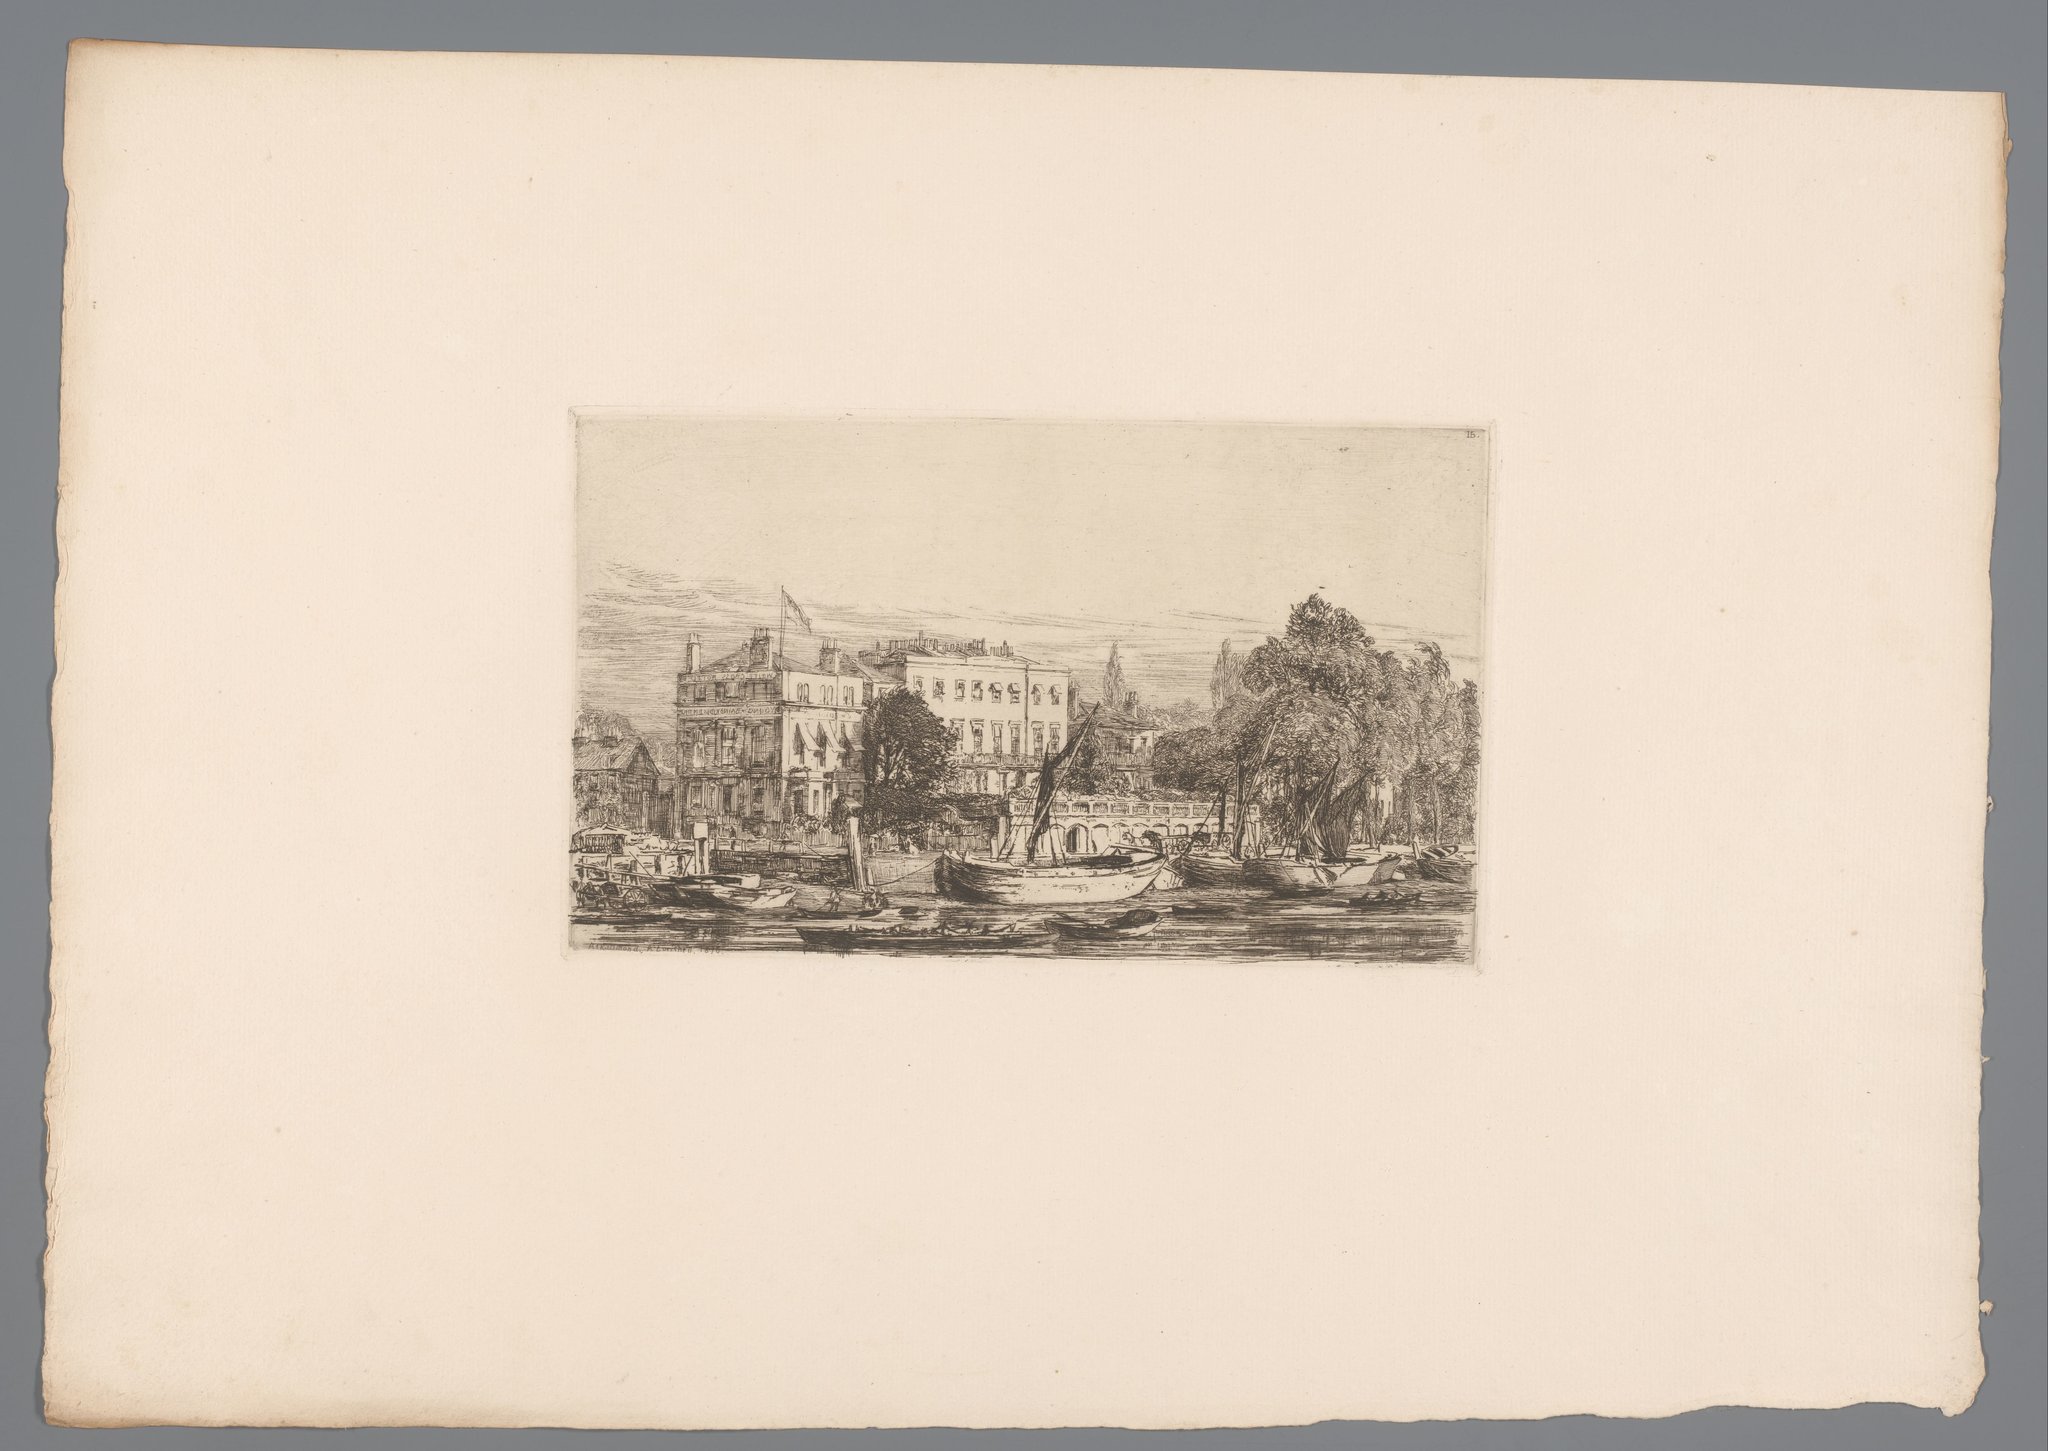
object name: print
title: À Richemond sur la Tamise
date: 1880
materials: paper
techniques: drypoint, etching, intaglio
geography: paris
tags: harbour, canals, waters (in city), london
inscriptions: collector's mark: Lugt 2760, collector's mark: Lugt 2228, watermark, collector's mark: ‘AFE v S’